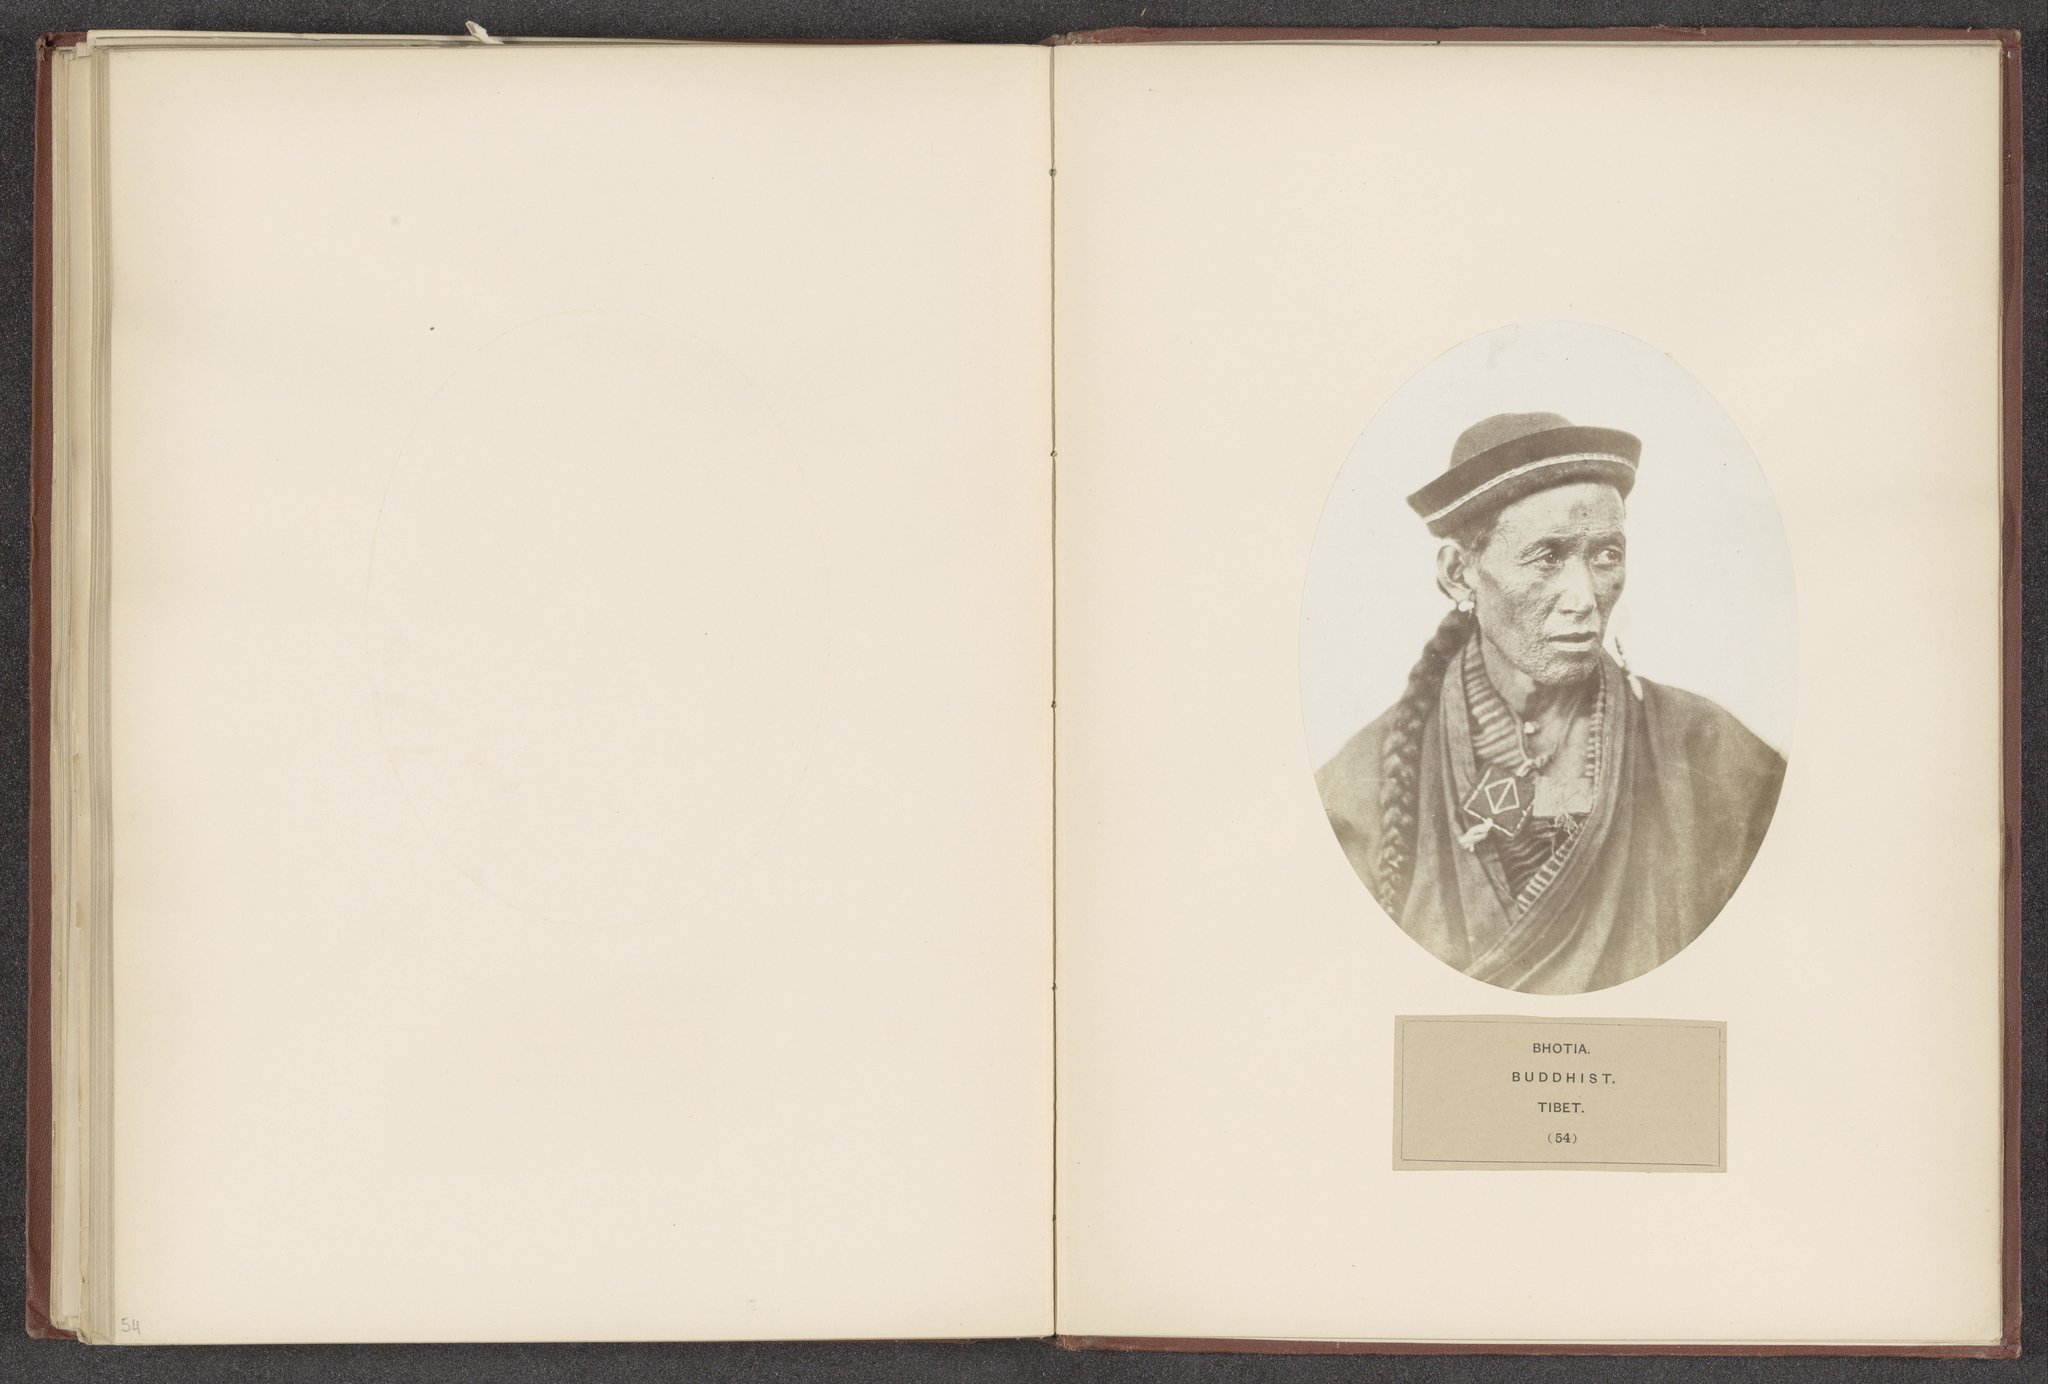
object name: page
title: Portrait of an unknown man from the Bhutia community of Tibet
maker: benjamin simpson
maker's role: fotograaf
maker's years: 1831-1923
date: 1858-1868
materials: photographic support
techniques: albumen print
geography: tibet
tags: hinduism, buddhism, jainism, human races; peoples; nationalities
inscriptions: number: ‘(54)’, inscription: ‘BHOTIA./ BUDDHIST./ TIBET.’